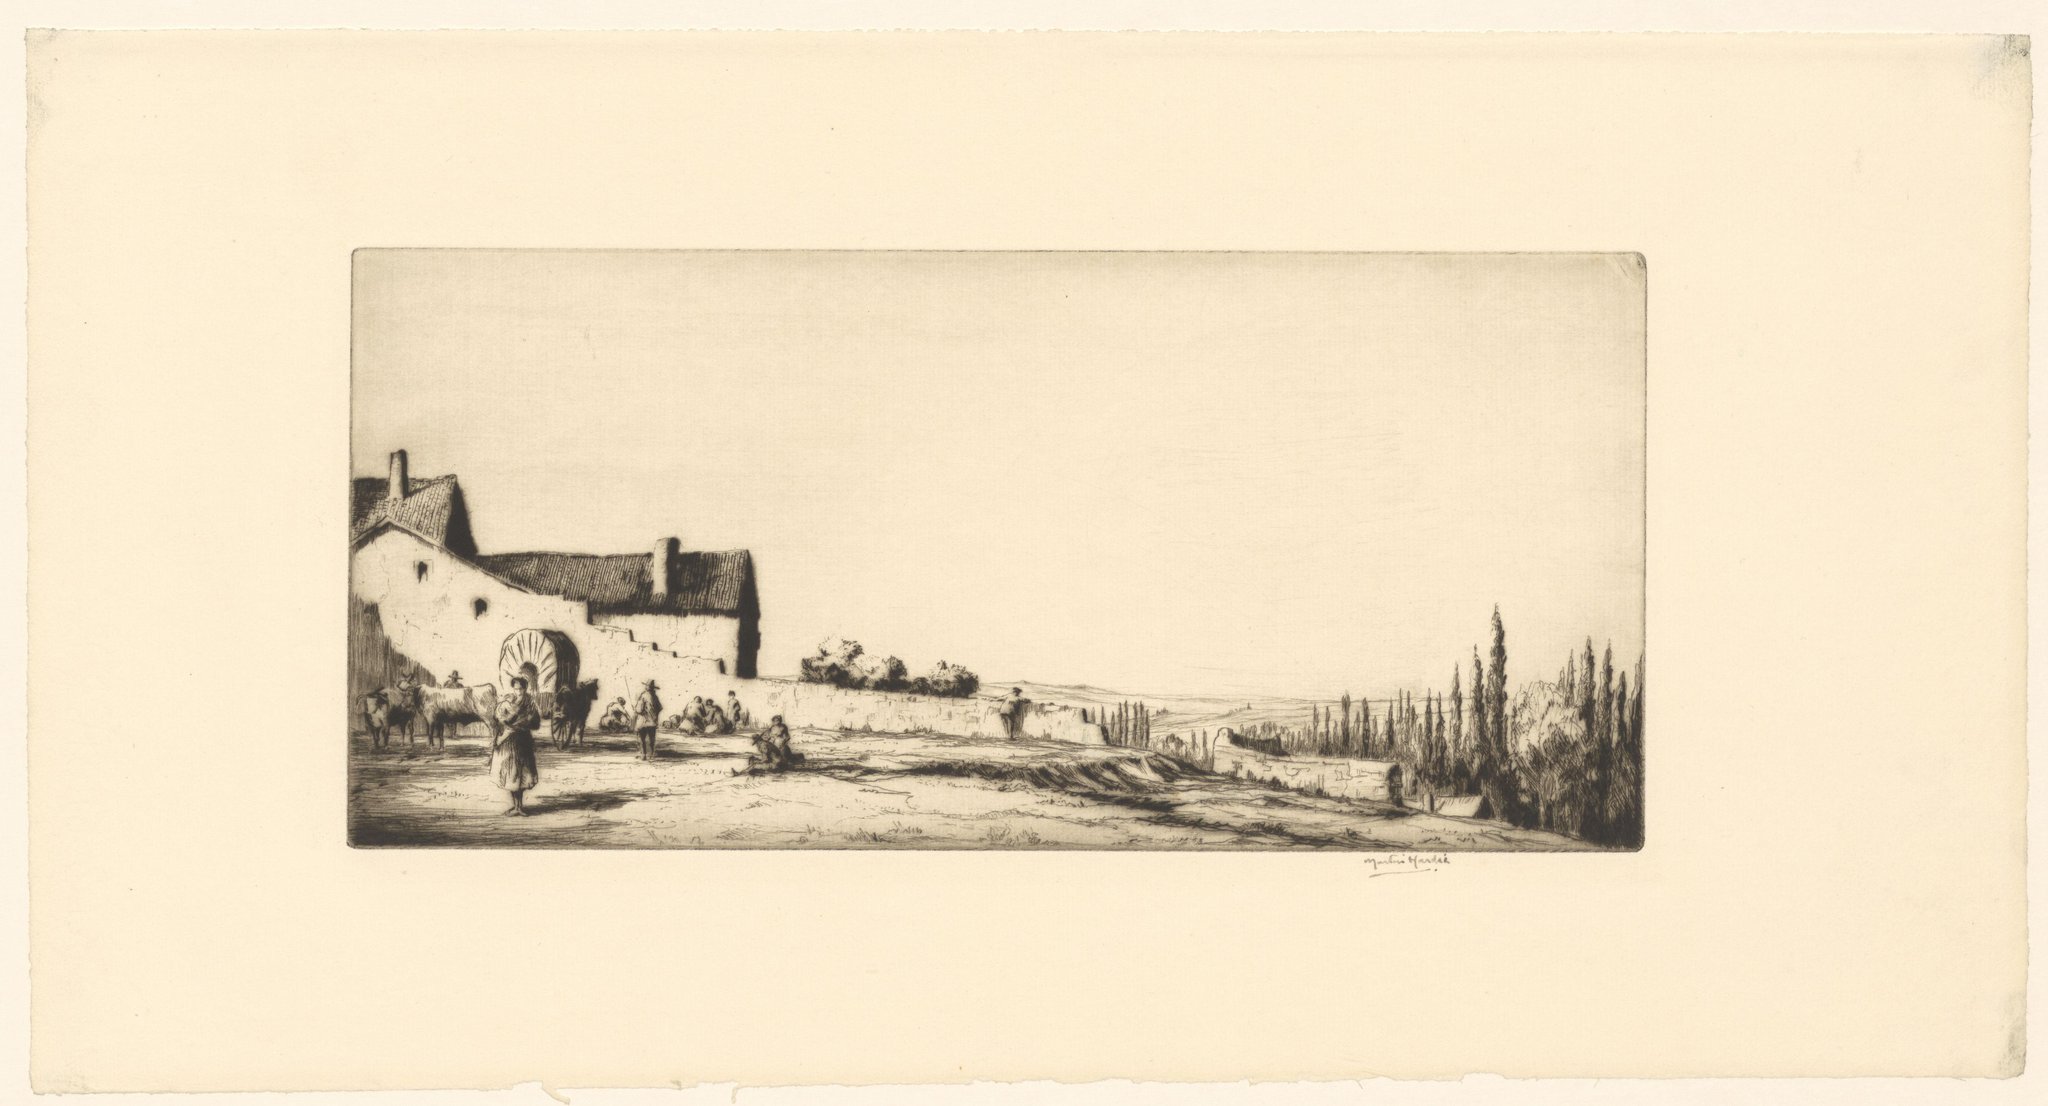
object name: print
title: Spanish Gipsies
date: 1928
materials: paper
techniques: drypoint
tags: low hill country (+ landscape with figures, staffage), covered wagon, hooded wagon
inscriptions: annotation: ‘Martin Hardie’, collector's mark: Lugt 2228, collector's mark: Lugt 2760